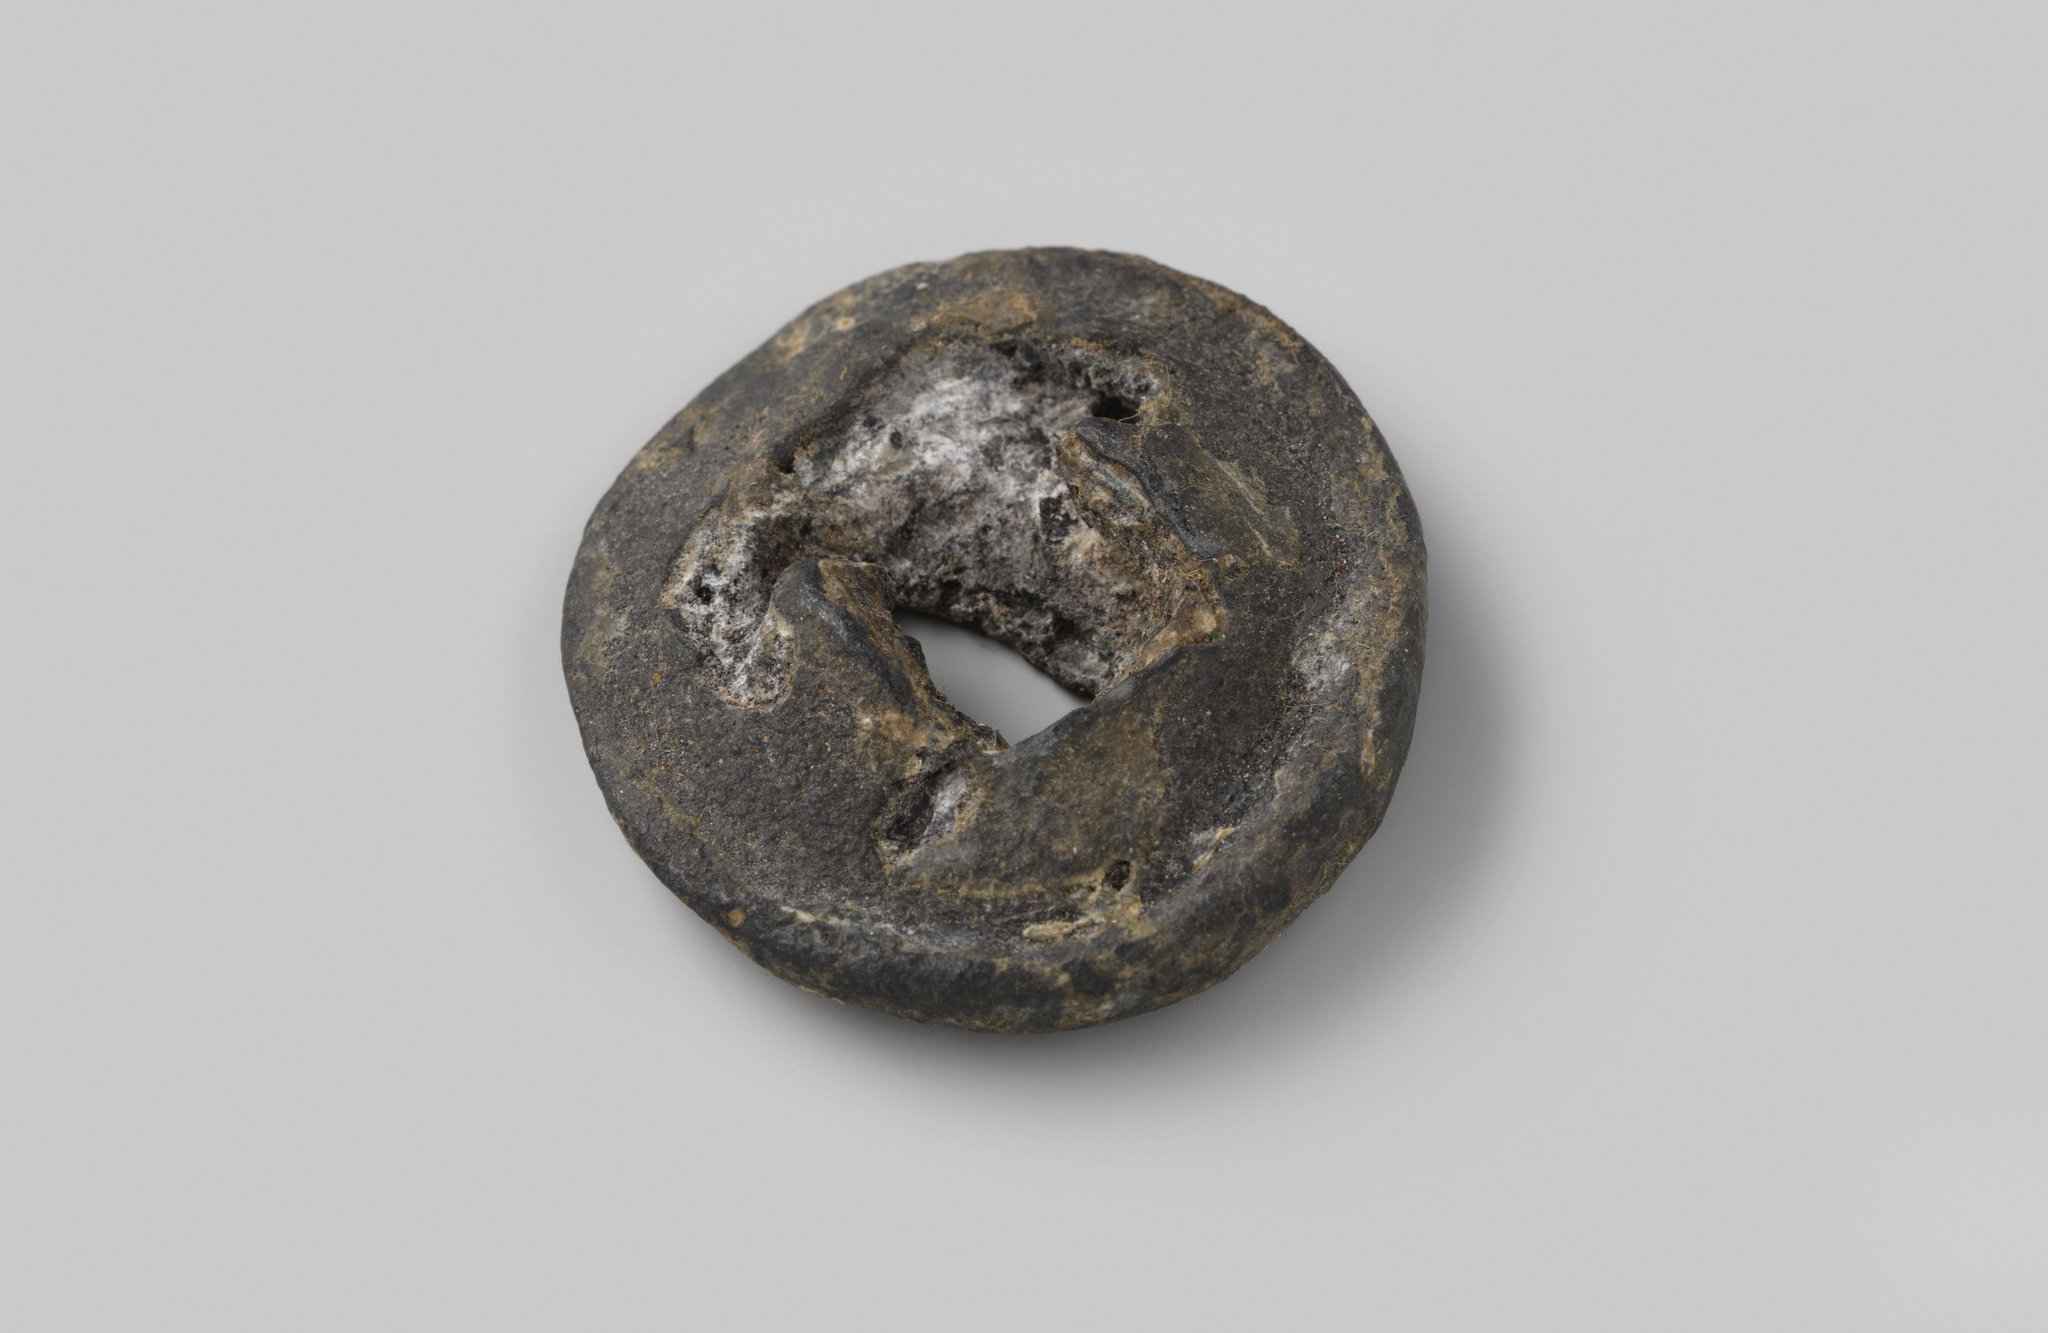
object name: fragment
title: Schijfvormig fragment uit het wrak van de Oost-Indiëvaarder Hollandia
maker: Anonymous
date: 1700-1743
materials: lead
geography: netherlands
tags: verenigde oostindische compagnie, hollandia (schip), annet